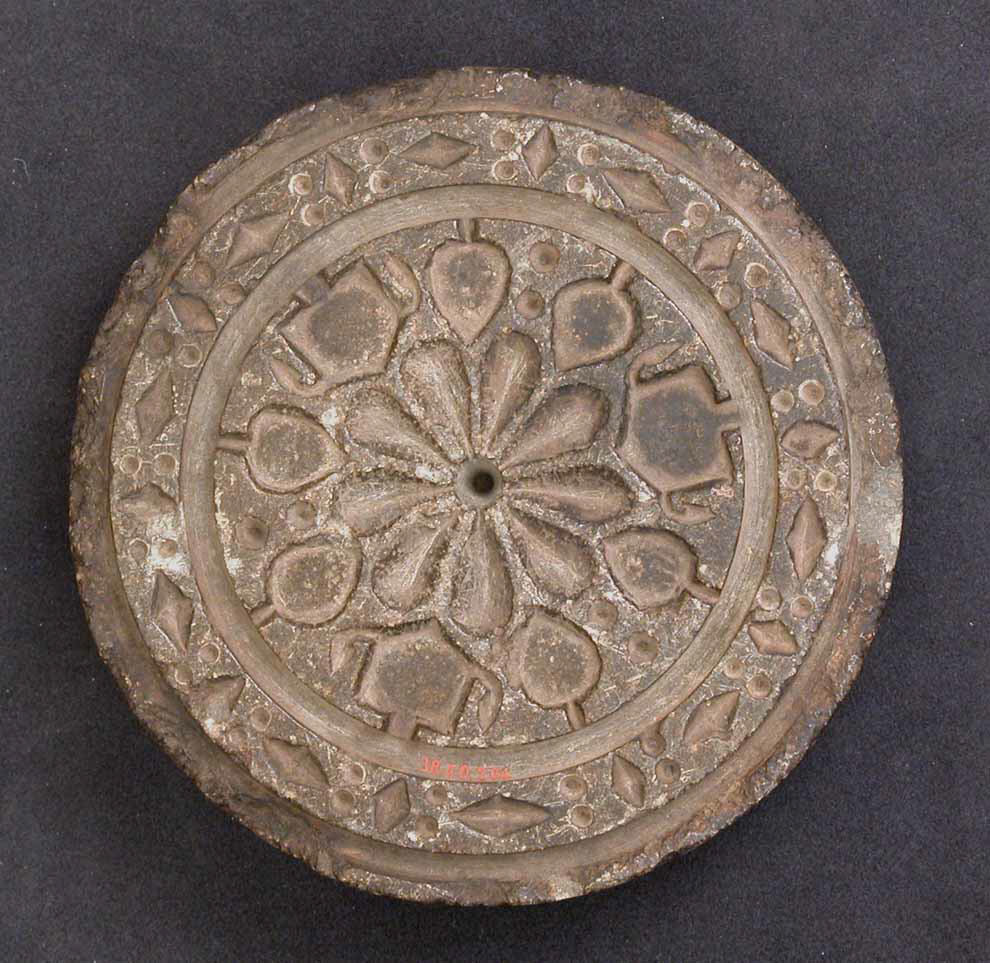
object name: die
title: Die (?)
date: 801-1100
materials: stone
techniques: carving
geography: iran